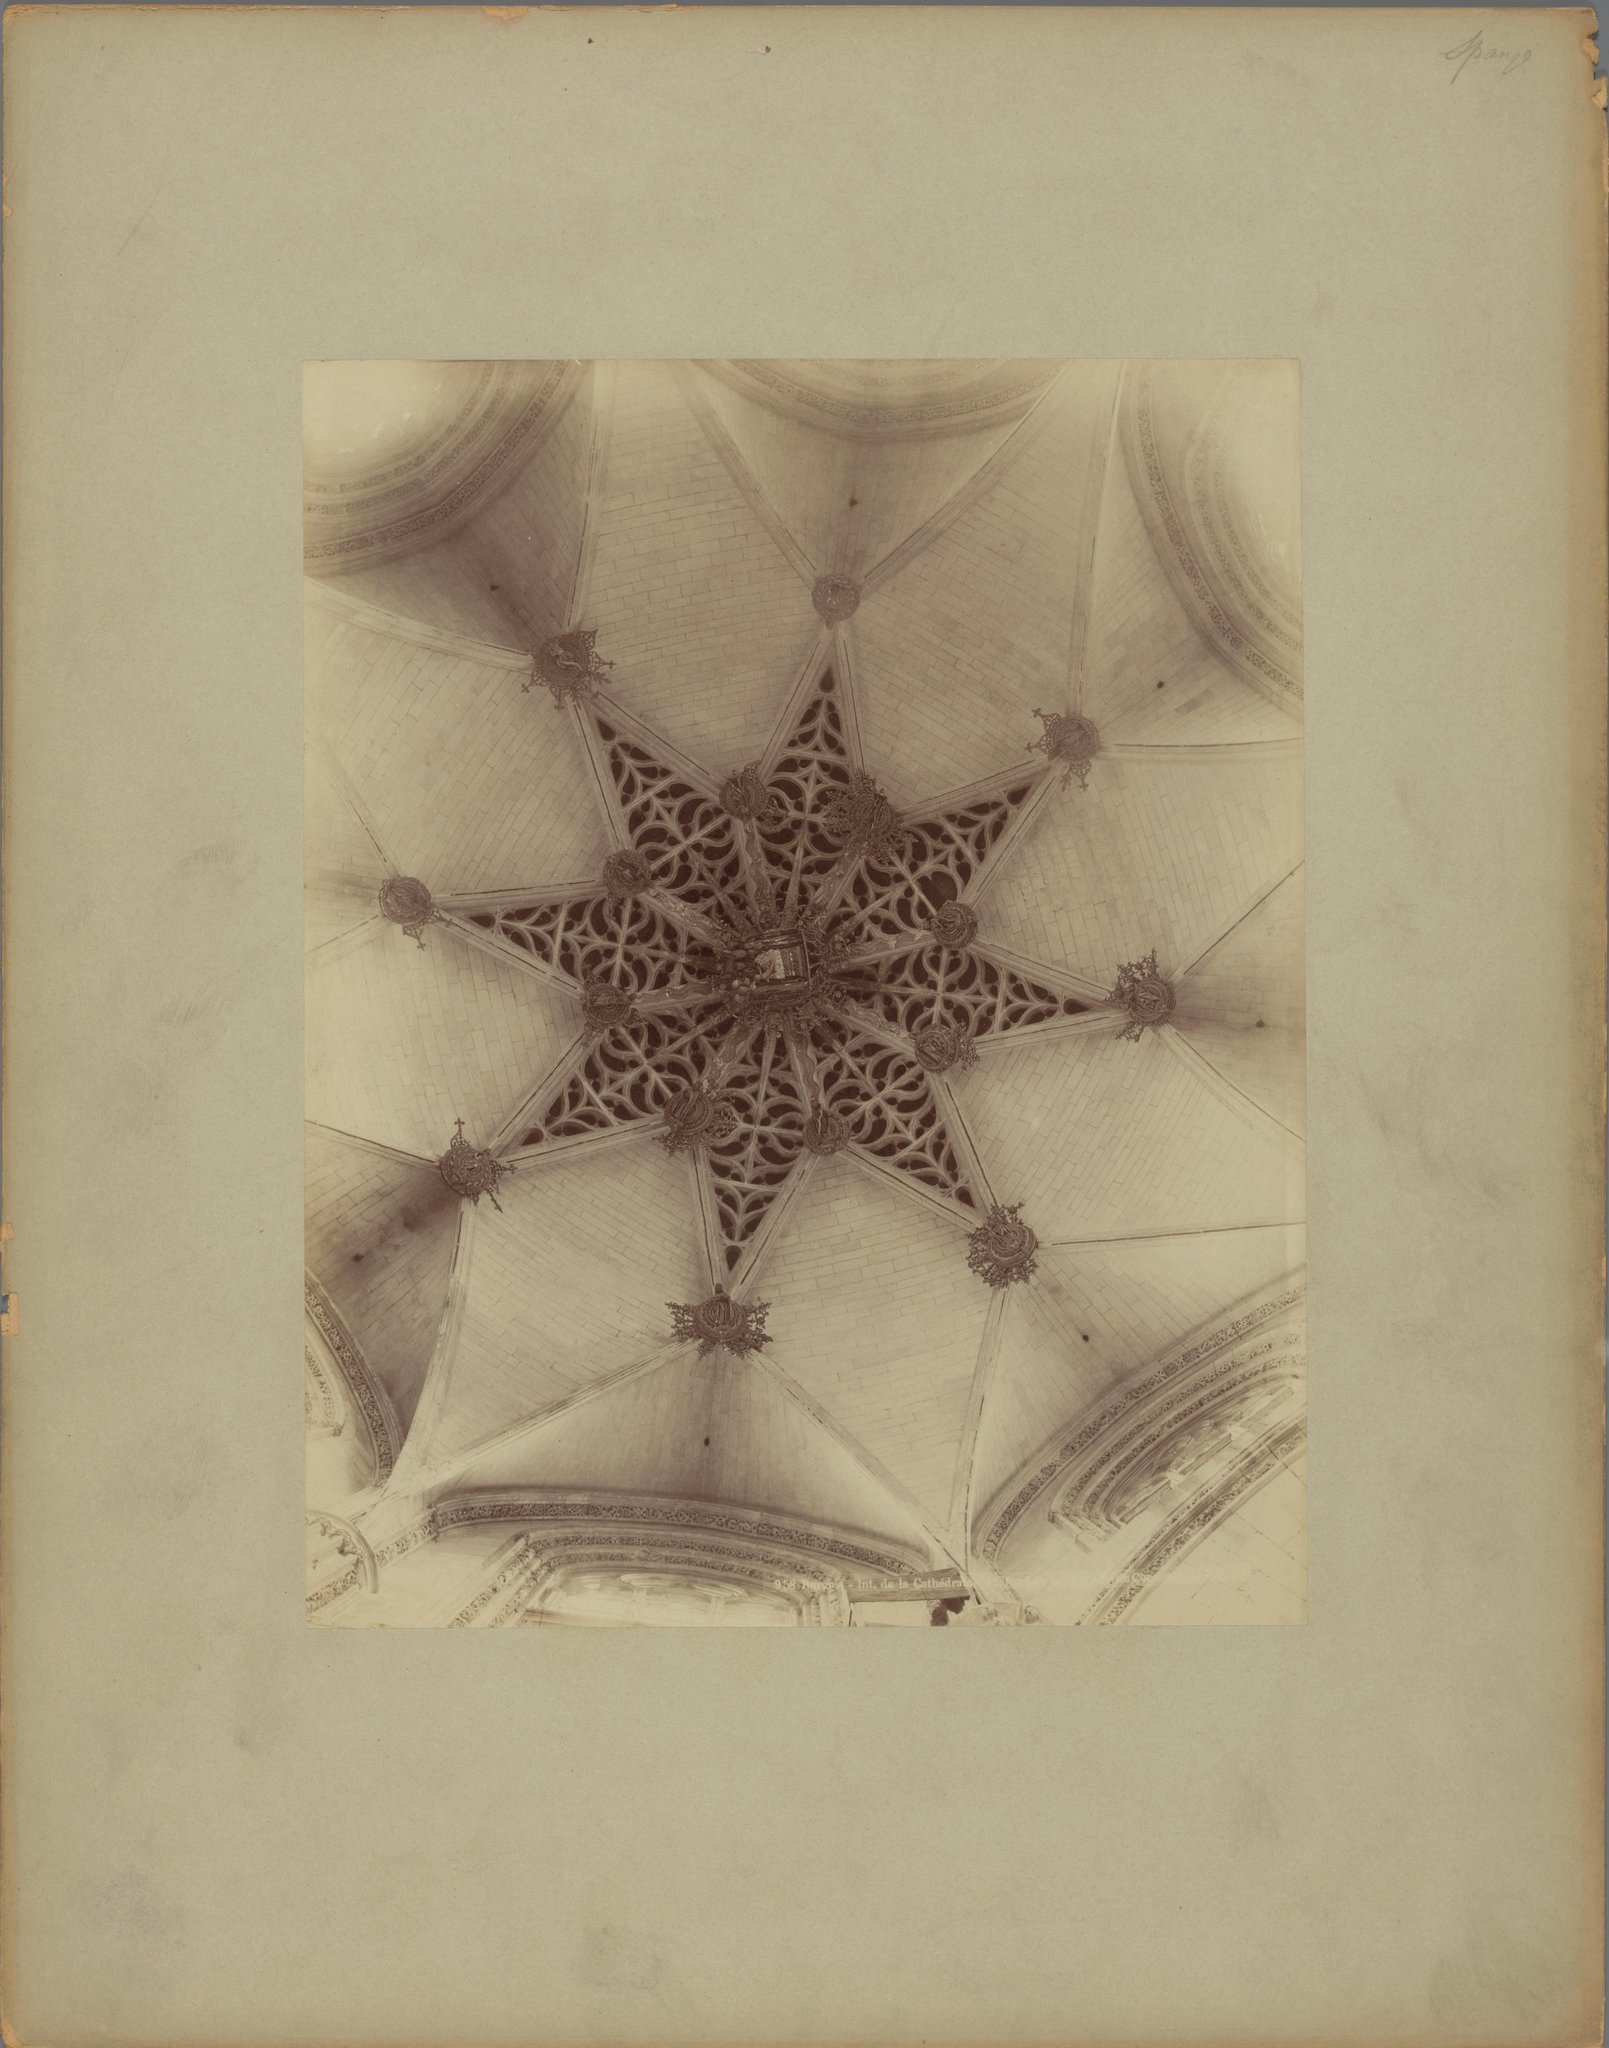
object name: photograph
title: La Cathédrale. Ostensoir en Argent Cordoue.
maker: Anonymous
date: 1875-1900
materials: cardboard, photographic support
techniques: albumen print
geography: mezquita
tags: ostensorium, monstrance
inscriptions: number: ‘767’, collector's mark: Lugt 3937